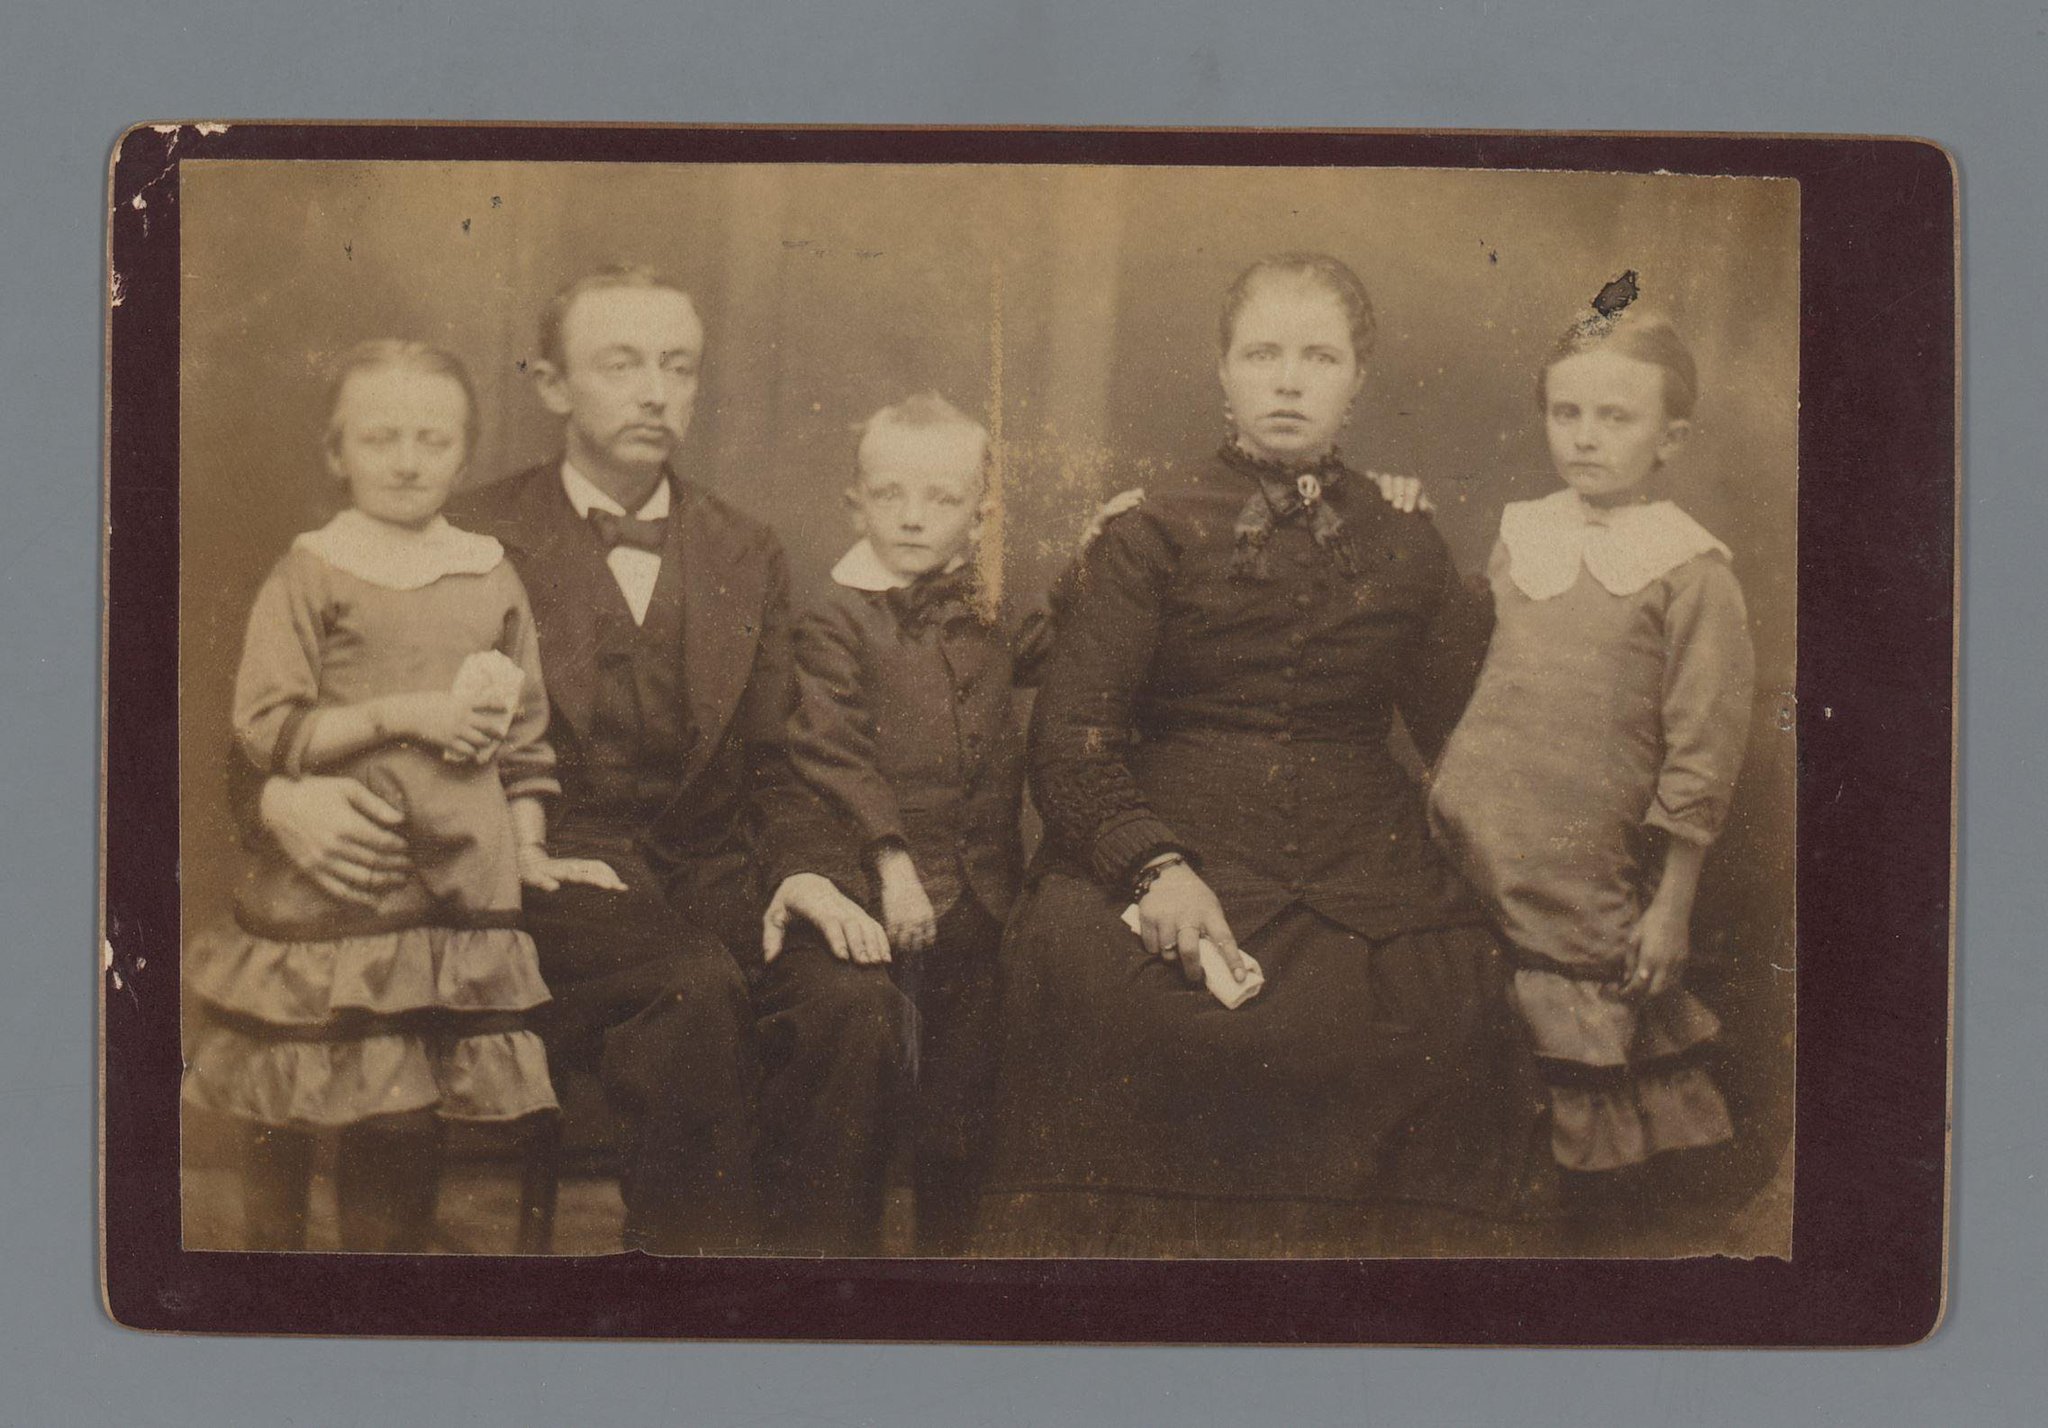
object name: cabinet photograph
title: Groepsportret van Sieber Revenga met zijn vrouw en drie kinderen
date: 1880-1900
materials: cardboard, photographic support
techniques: albumen print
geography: paterson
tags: family group, especially parents with their child(ren)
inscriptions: inscription: ‘Siever Revenga met tweede vrouw en kinderen uit eerste huwelijk’, name: ‘Simpson's Studio No. 169 Main Street Next to Odd Fellow's Hall, Paterson, N.J.’